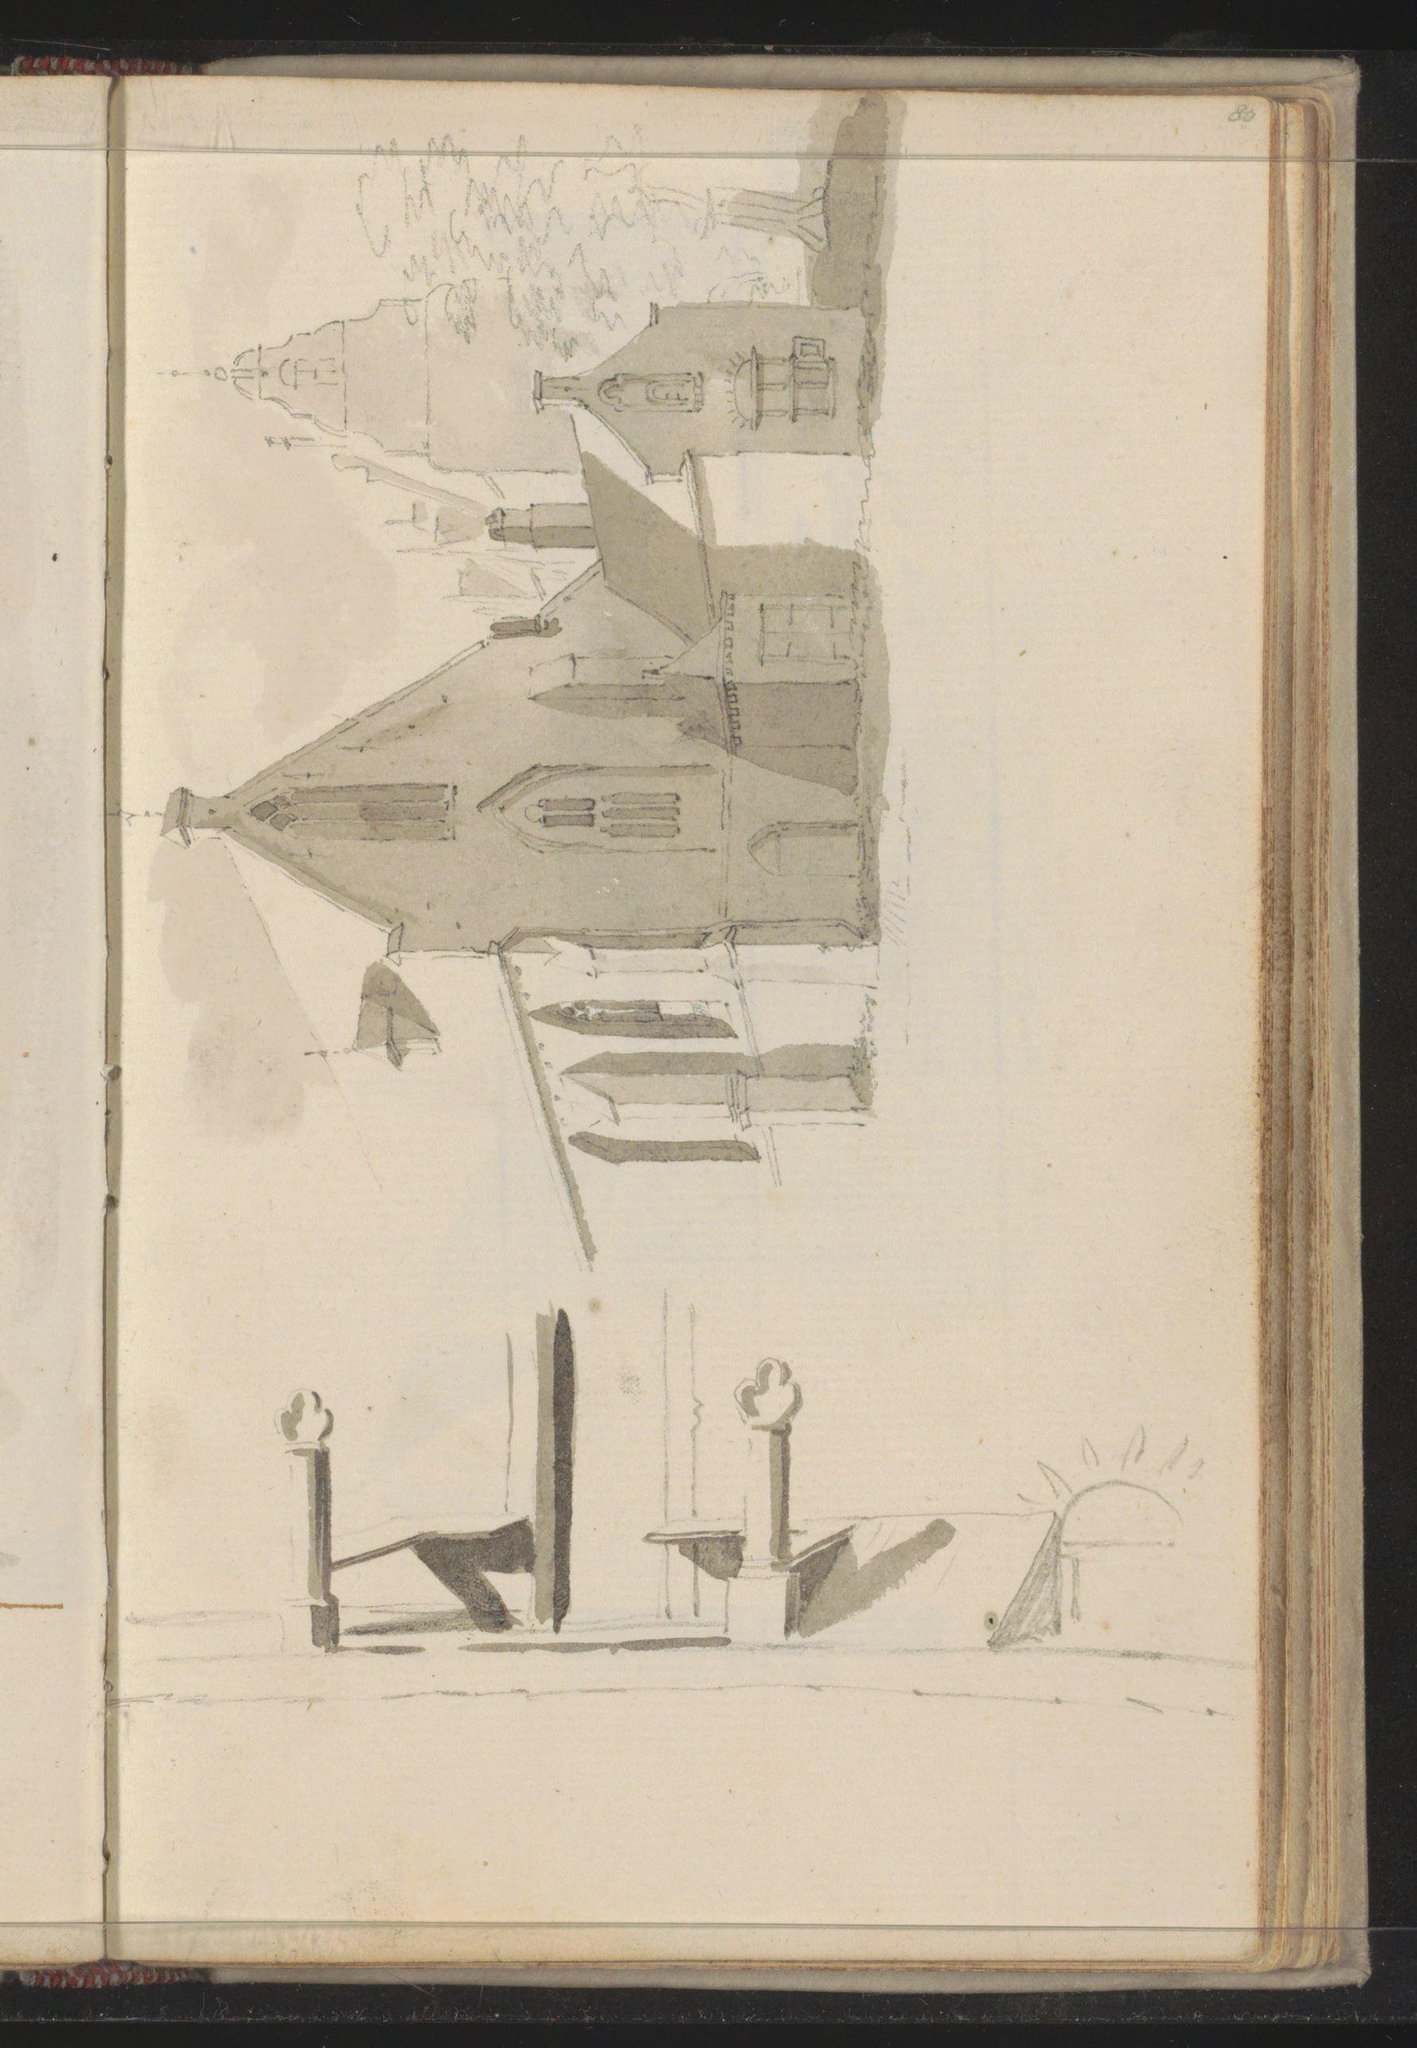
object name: sketchbook leaf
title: Exterieur van een kerk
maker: johannes huibert prins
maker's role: draughtsman, painter, print maker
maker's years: 1757-1806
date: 1783-1797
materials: paper, pencil, watercolor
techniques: brush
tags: church (exterior)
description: Tevens een studie van een voordeur aan een straat. Pagina 80 uit een schetsboek met 175 pagina's.